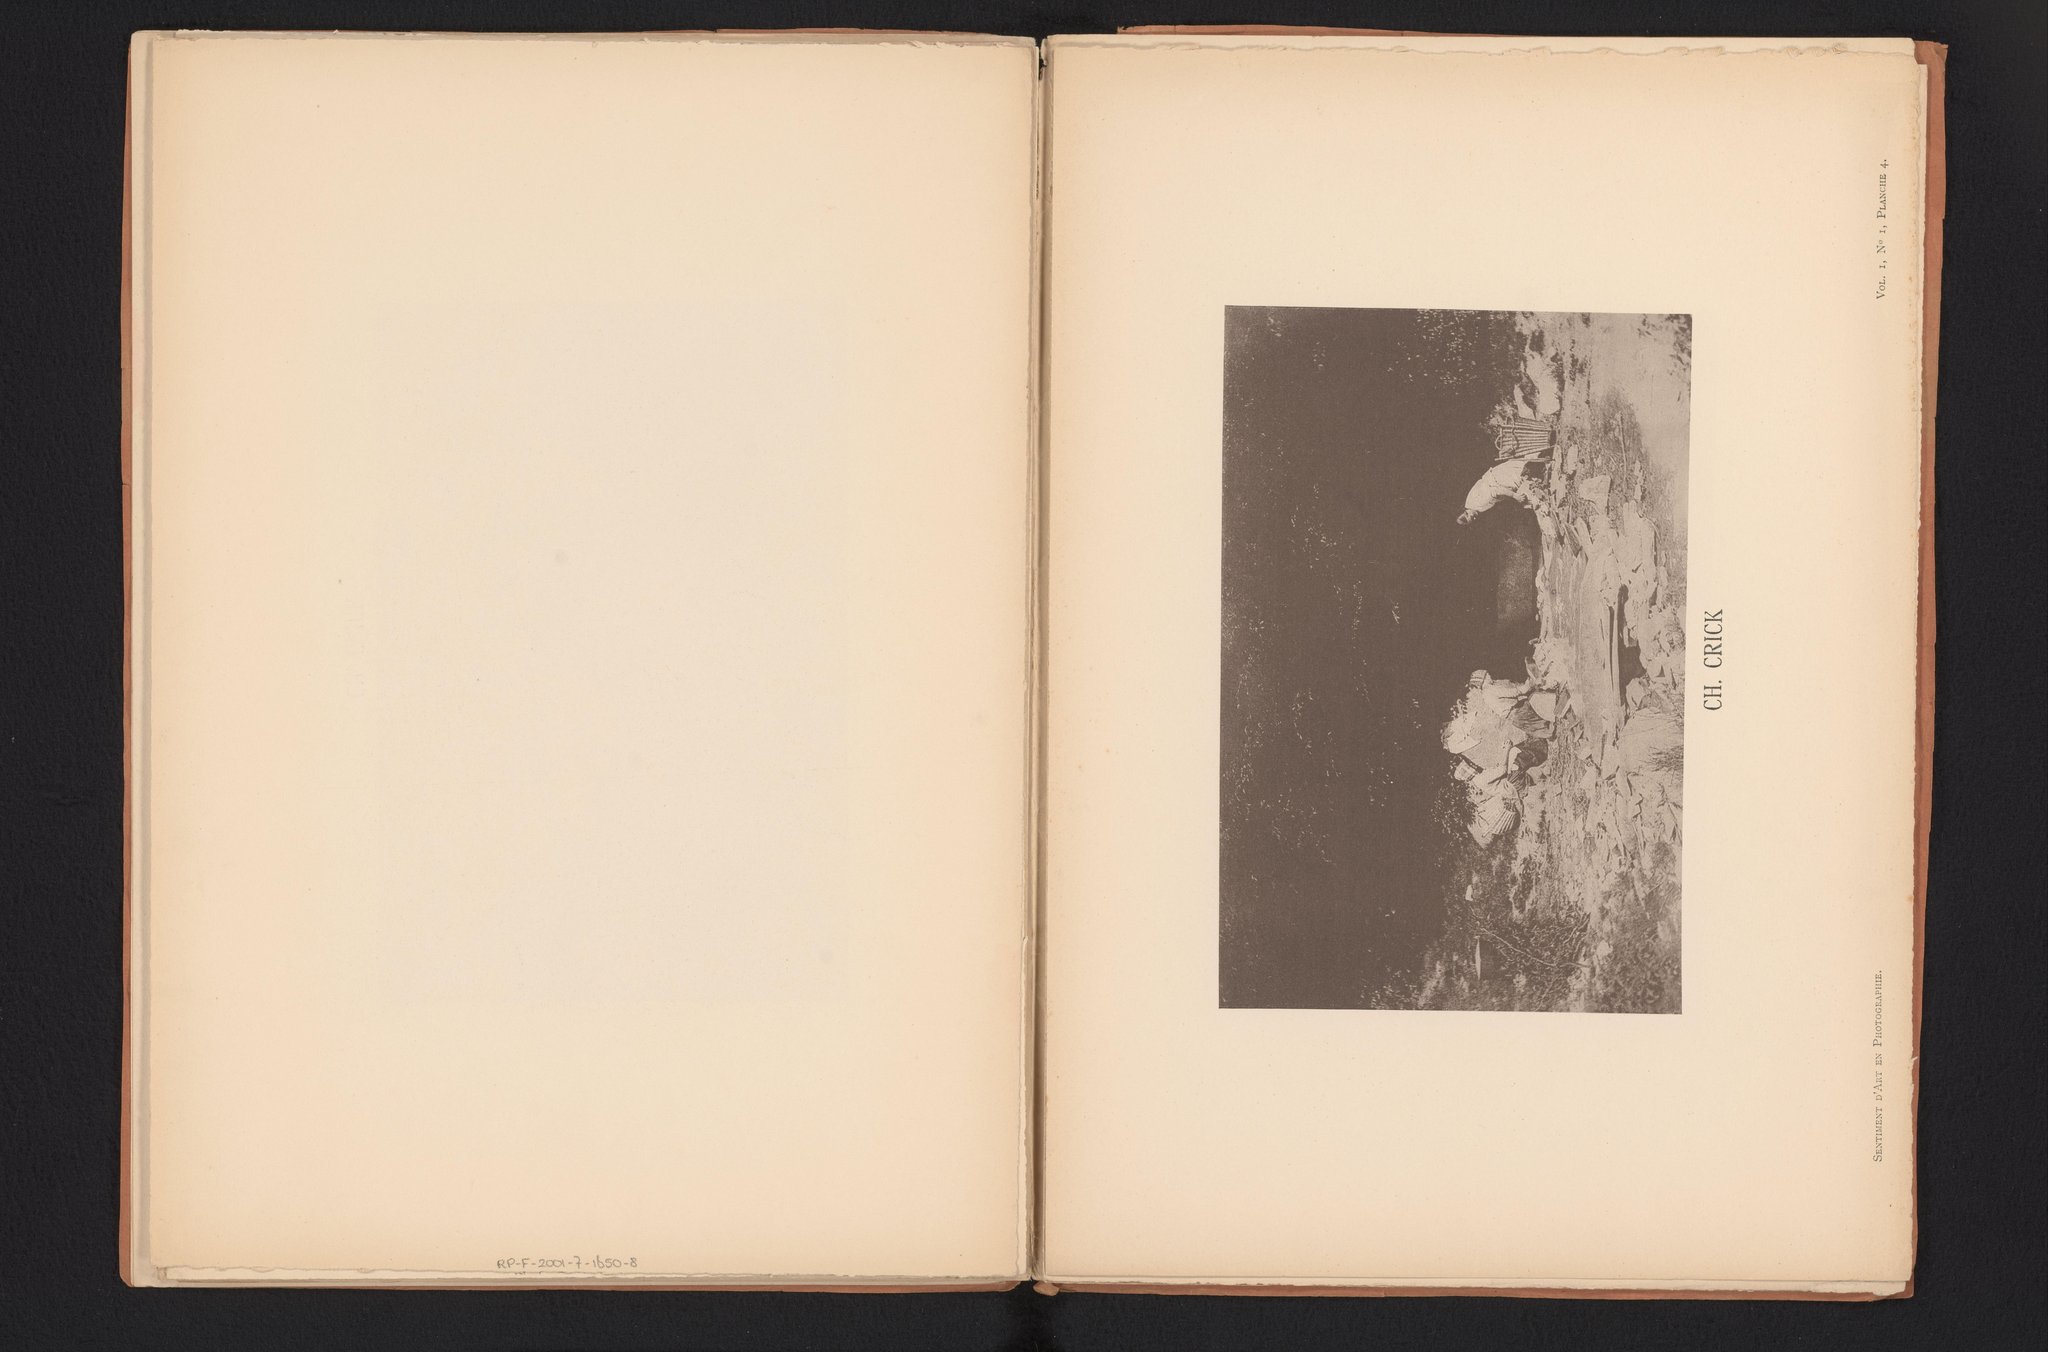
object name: photomechanical print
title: Drie vrouwen wassen kleding aan de oever van een beek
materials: paper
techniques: photograph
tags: laundering, adult woman (+ three persons)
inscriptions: number: ‘Vol. 1, No 1, Planche 4.’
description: Deze prent maakt deel uit van 8 omslagen met 22 tekstbladen en 89 prenten op losse bladen in en tussen de omslagen.